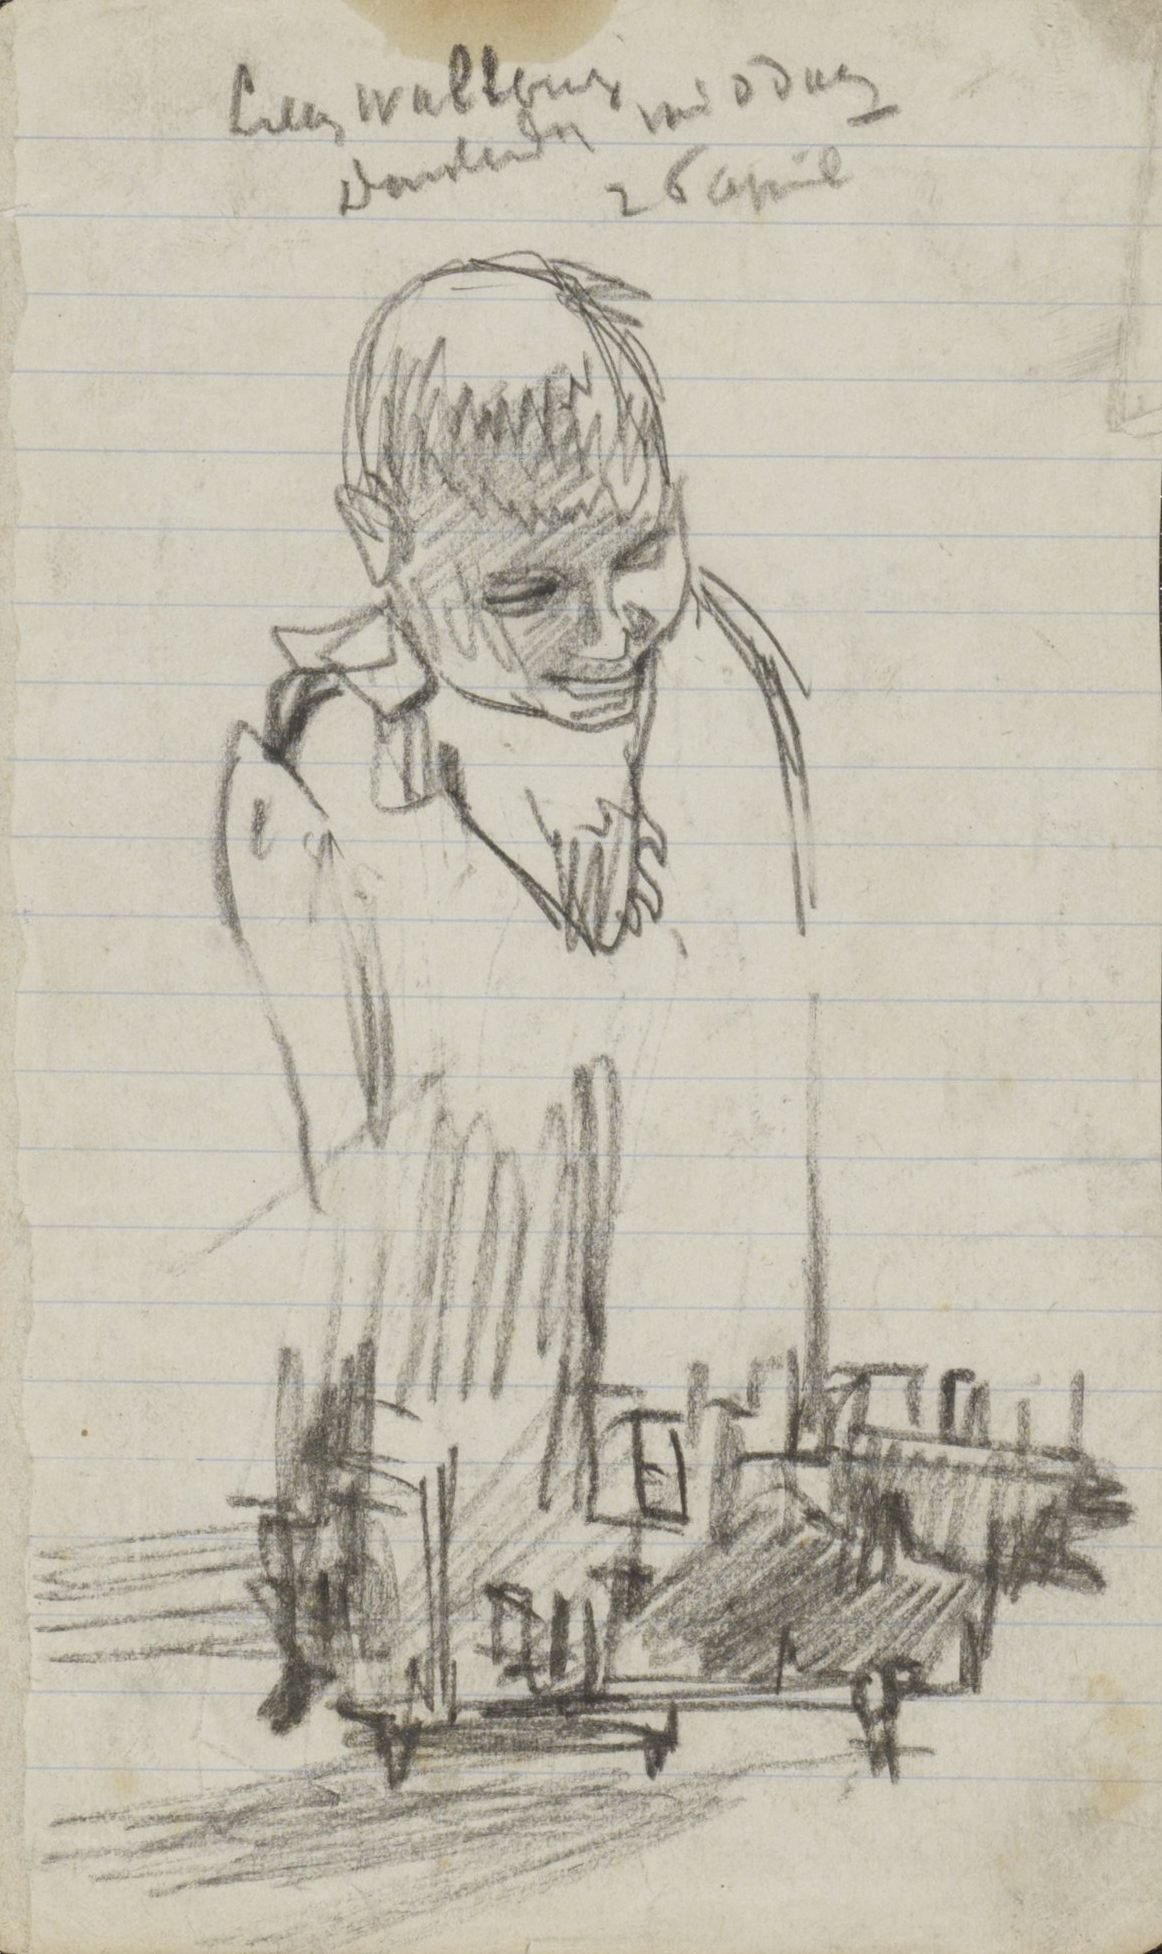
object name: drawing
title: Jongetje voor winkelraam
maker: george hendrik breitner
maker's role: draughtsman, painter, print maker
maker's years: 1857-1923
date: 1888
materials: chalk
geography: amsterdam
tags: boy (child between toddler and youth), street, amsterdam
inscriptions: annotation: ‘Lilly Wallens[?]/ Donderdag middag/ 26 april’